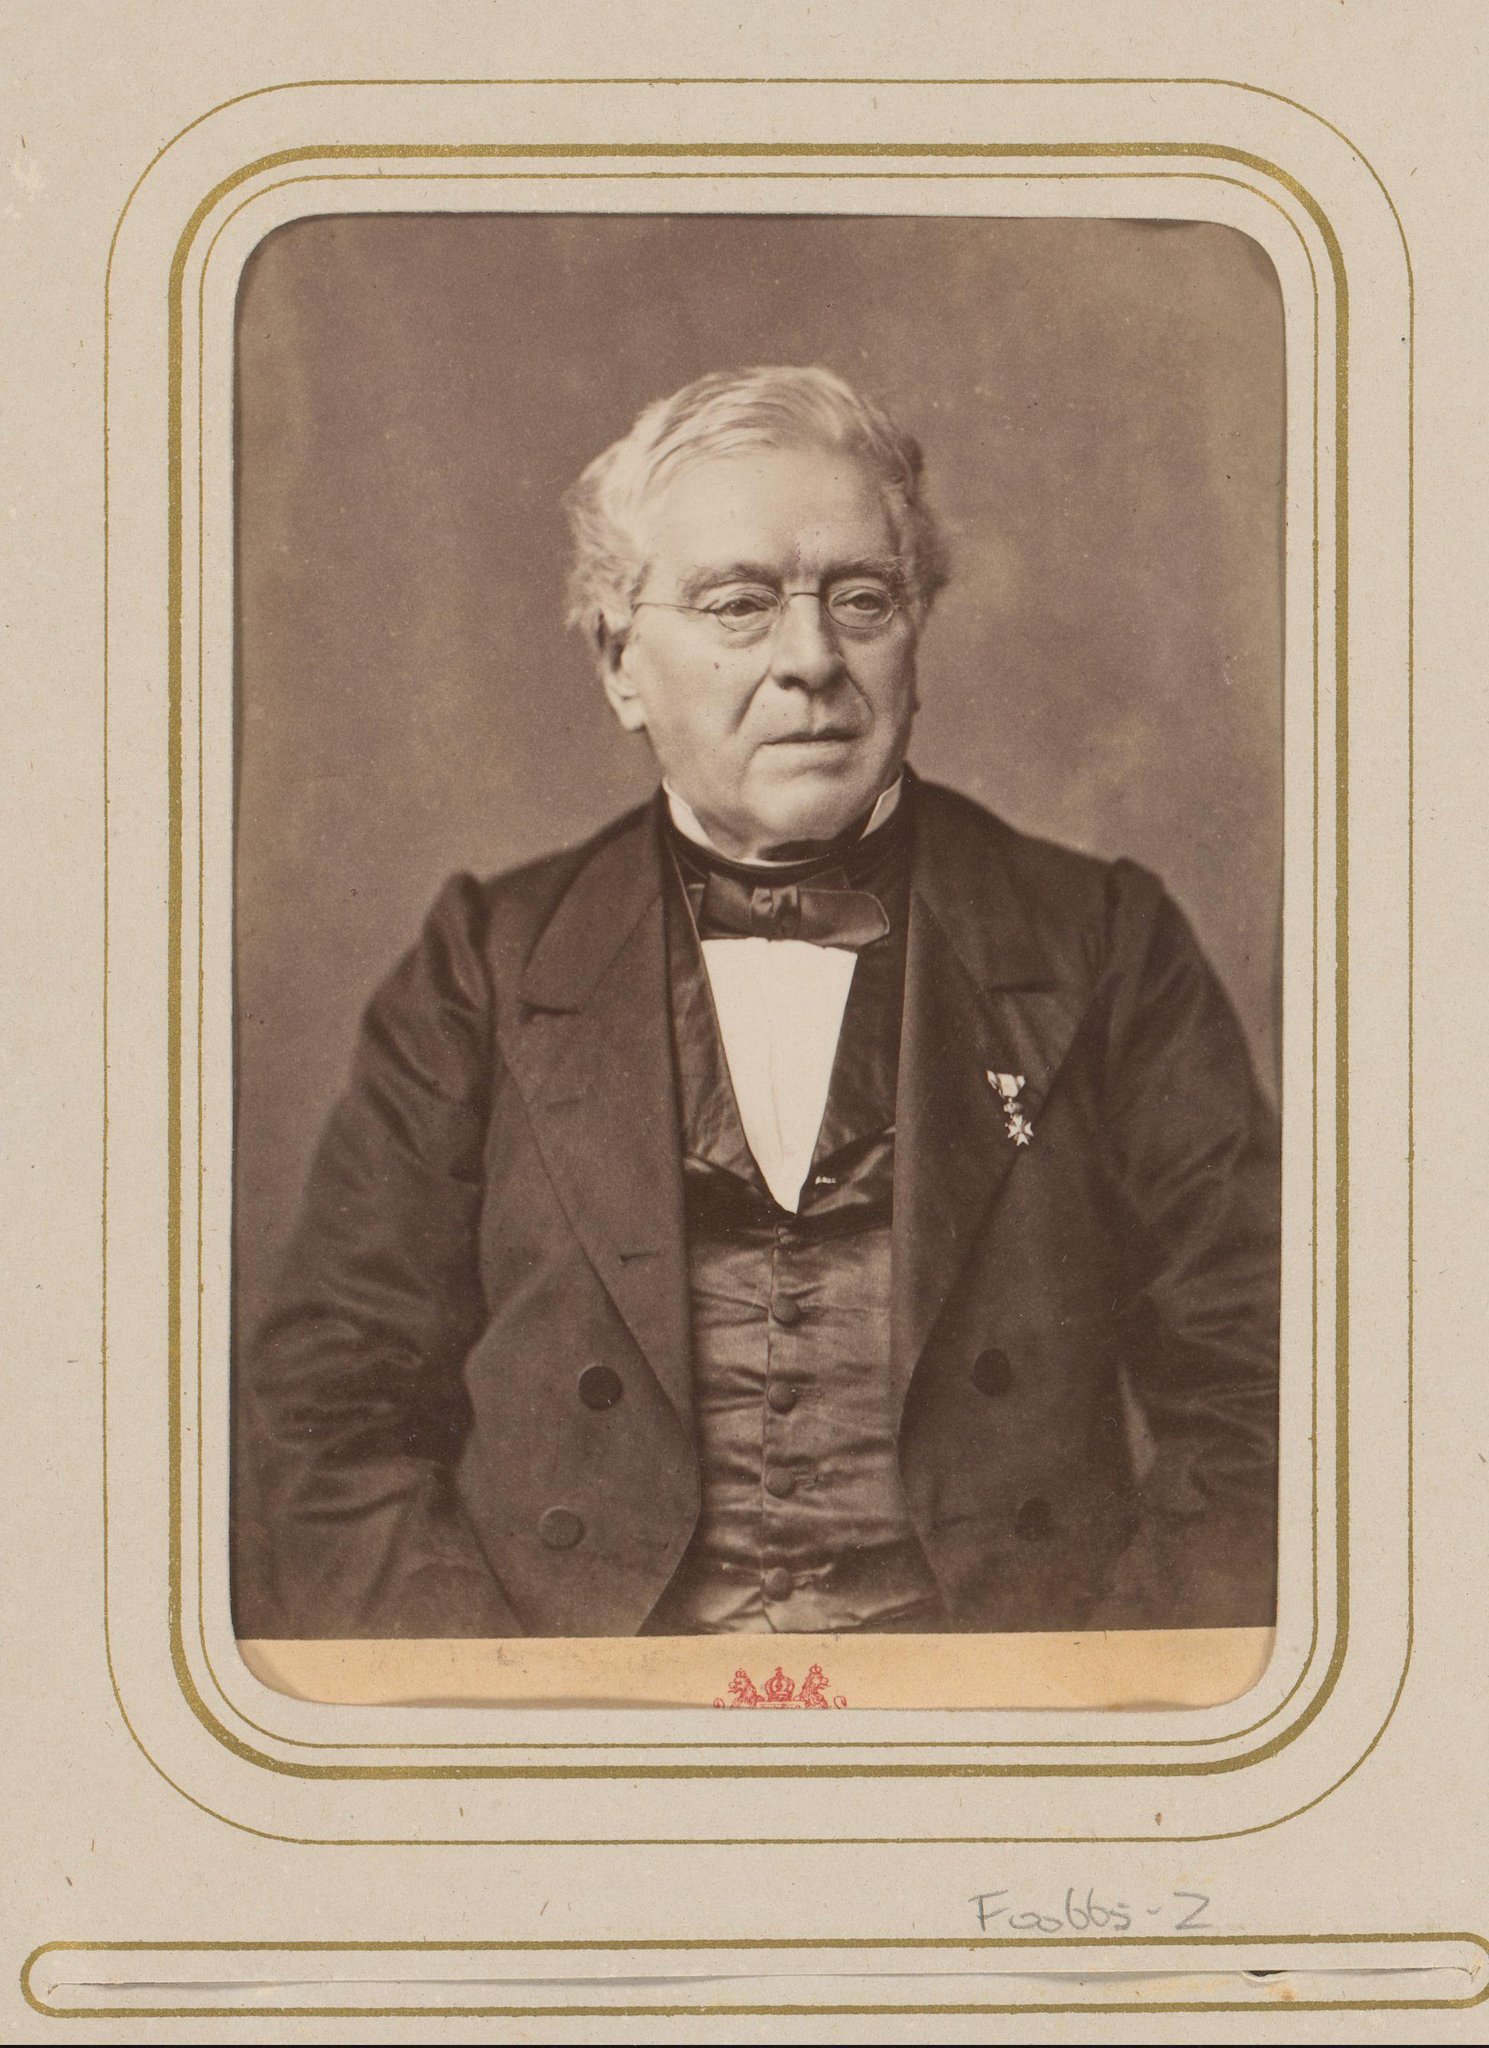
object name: album leaf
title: Portret van een man man met bril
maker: thomas martin staas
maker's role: fotograaf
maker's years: 1844-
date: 1882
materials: cardboard, photographic support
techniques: albumen print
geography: leeuwarden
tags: eyeglasses, spectacles, historical persons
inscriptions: date: ‘23 september 1882’